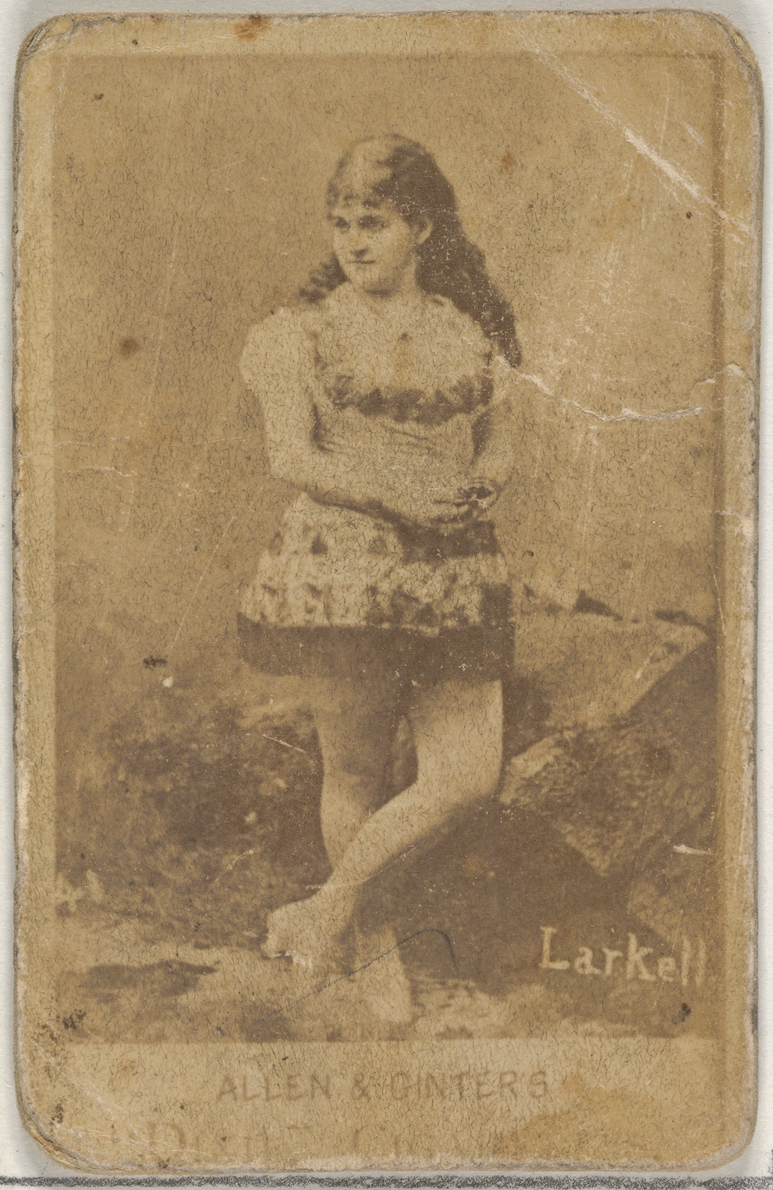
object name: photograph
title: Larkell, from the Actors and Actresses series (N45, Type 7) for Dixie Cigarettes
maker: allen & ginter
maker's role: publisher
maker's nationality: american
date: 1888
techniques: albumen silver print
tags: portraits,women,actresses